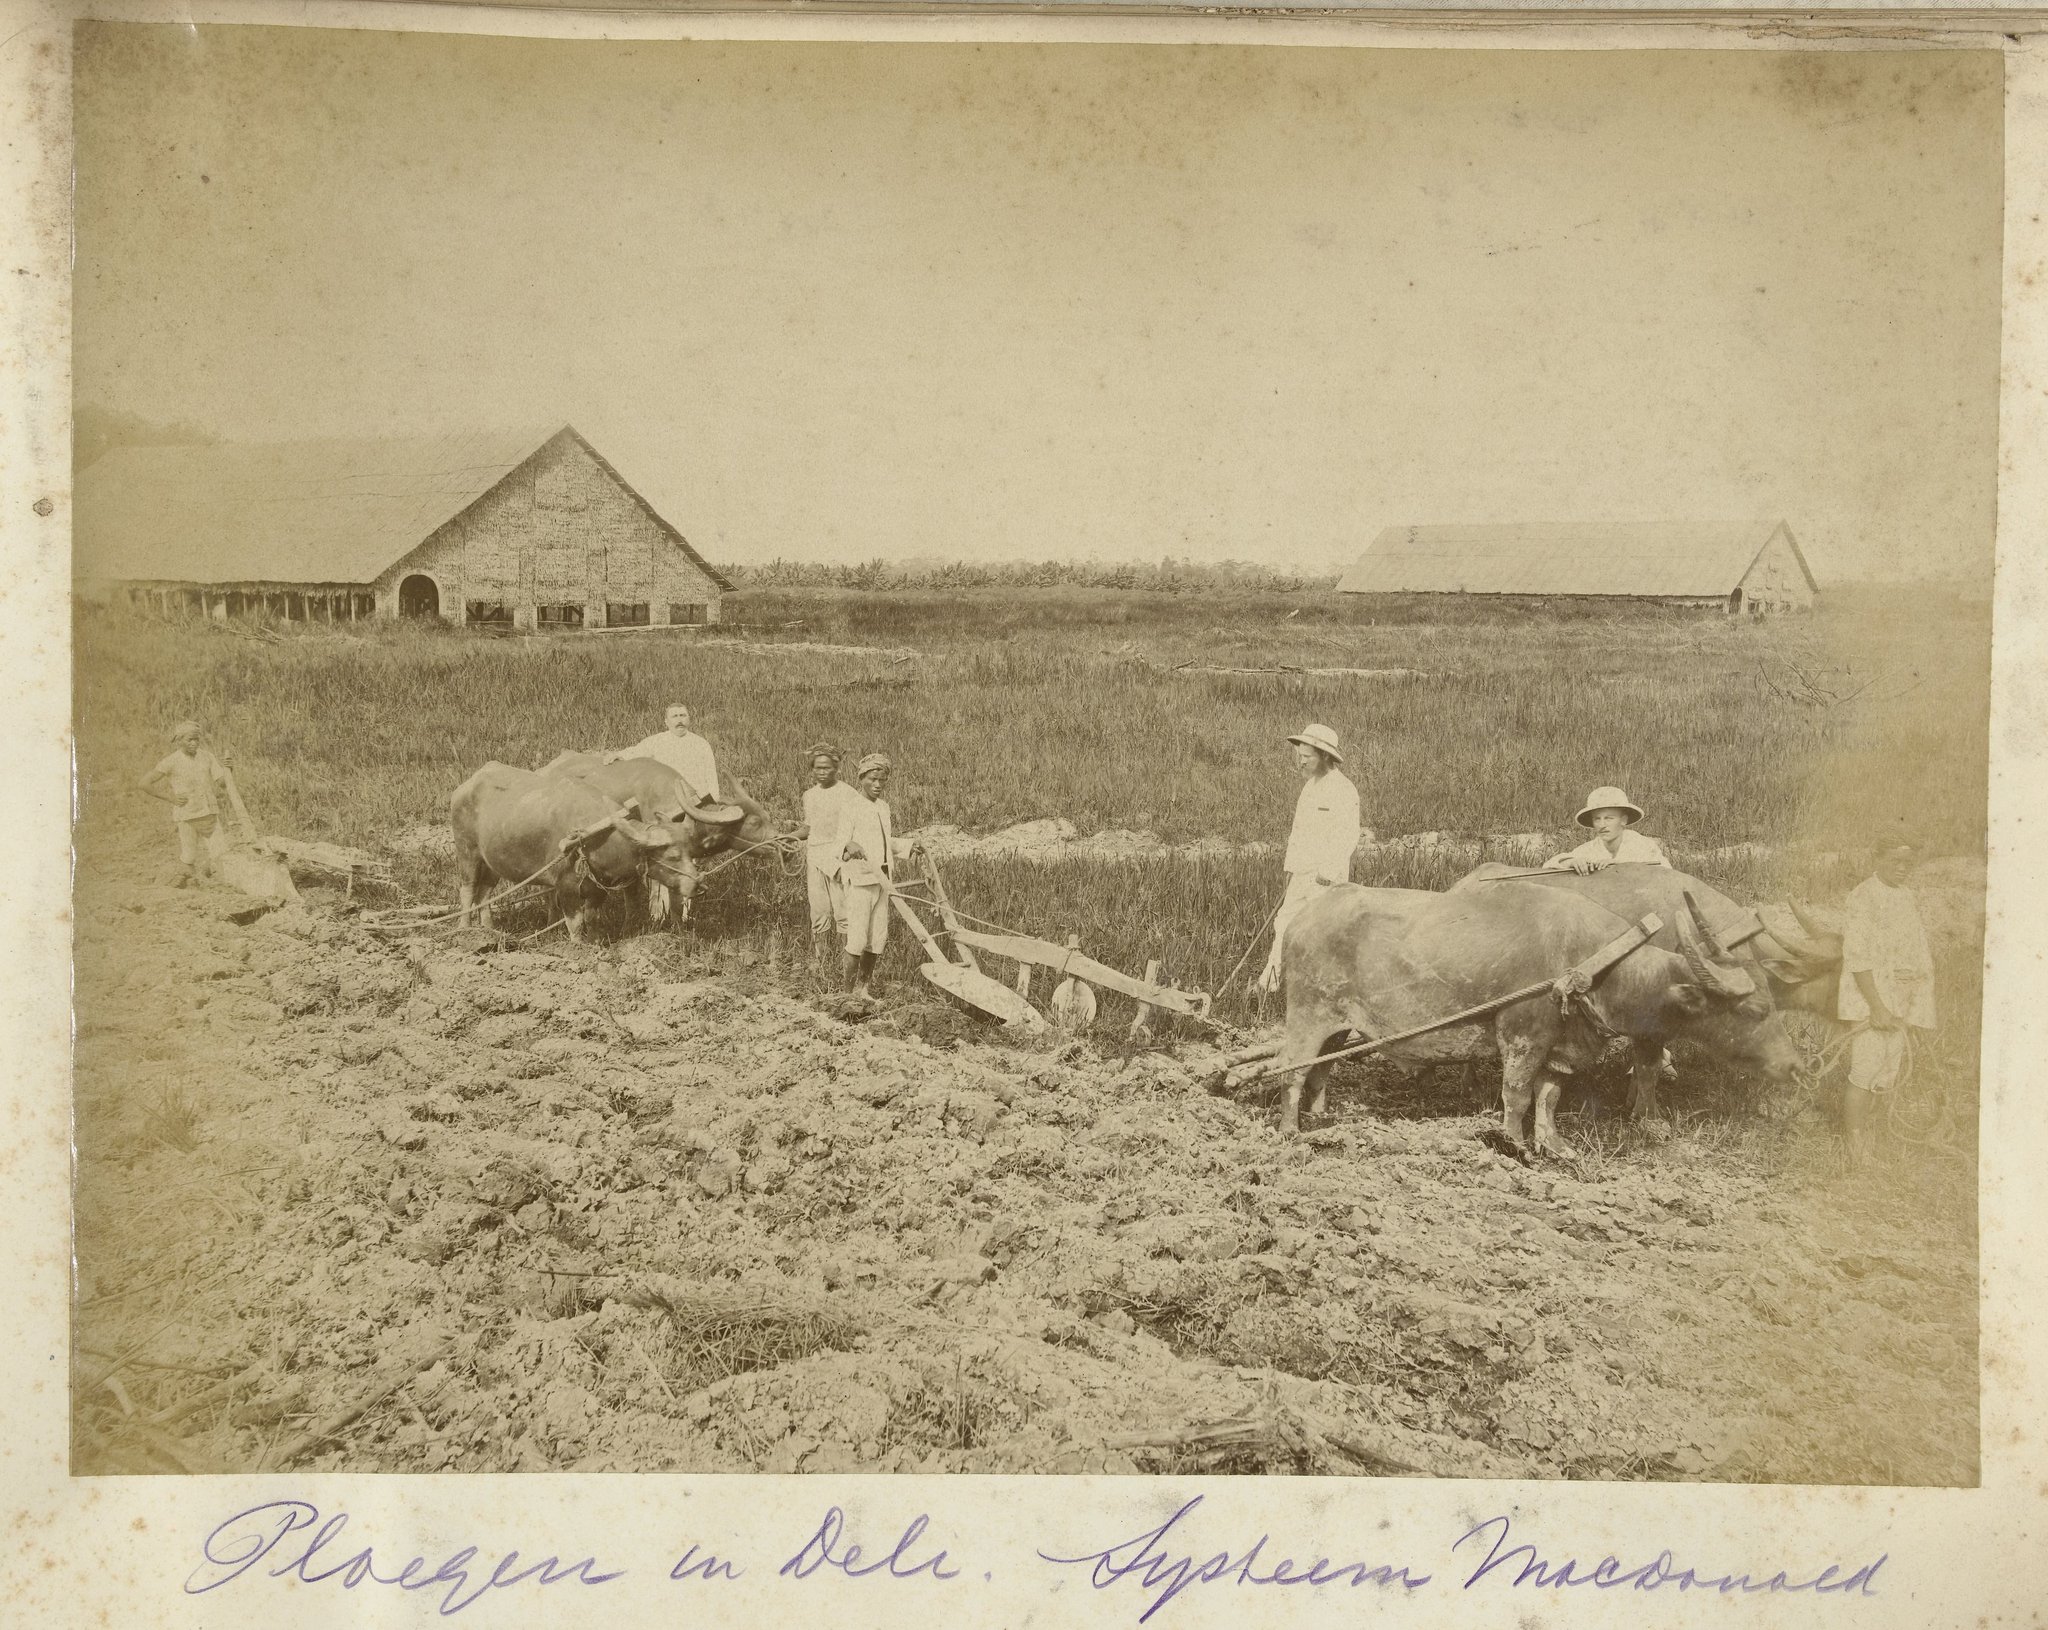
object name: photograph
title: Ploegen in Deli. Systeem Macdonald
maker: Anonymous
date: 1890-1910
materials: cardboard, paper, photographic support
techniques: gelatin silver print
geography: netherlands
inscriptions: caption: ‘Ploegen in Deli. Systeem Macdonald’